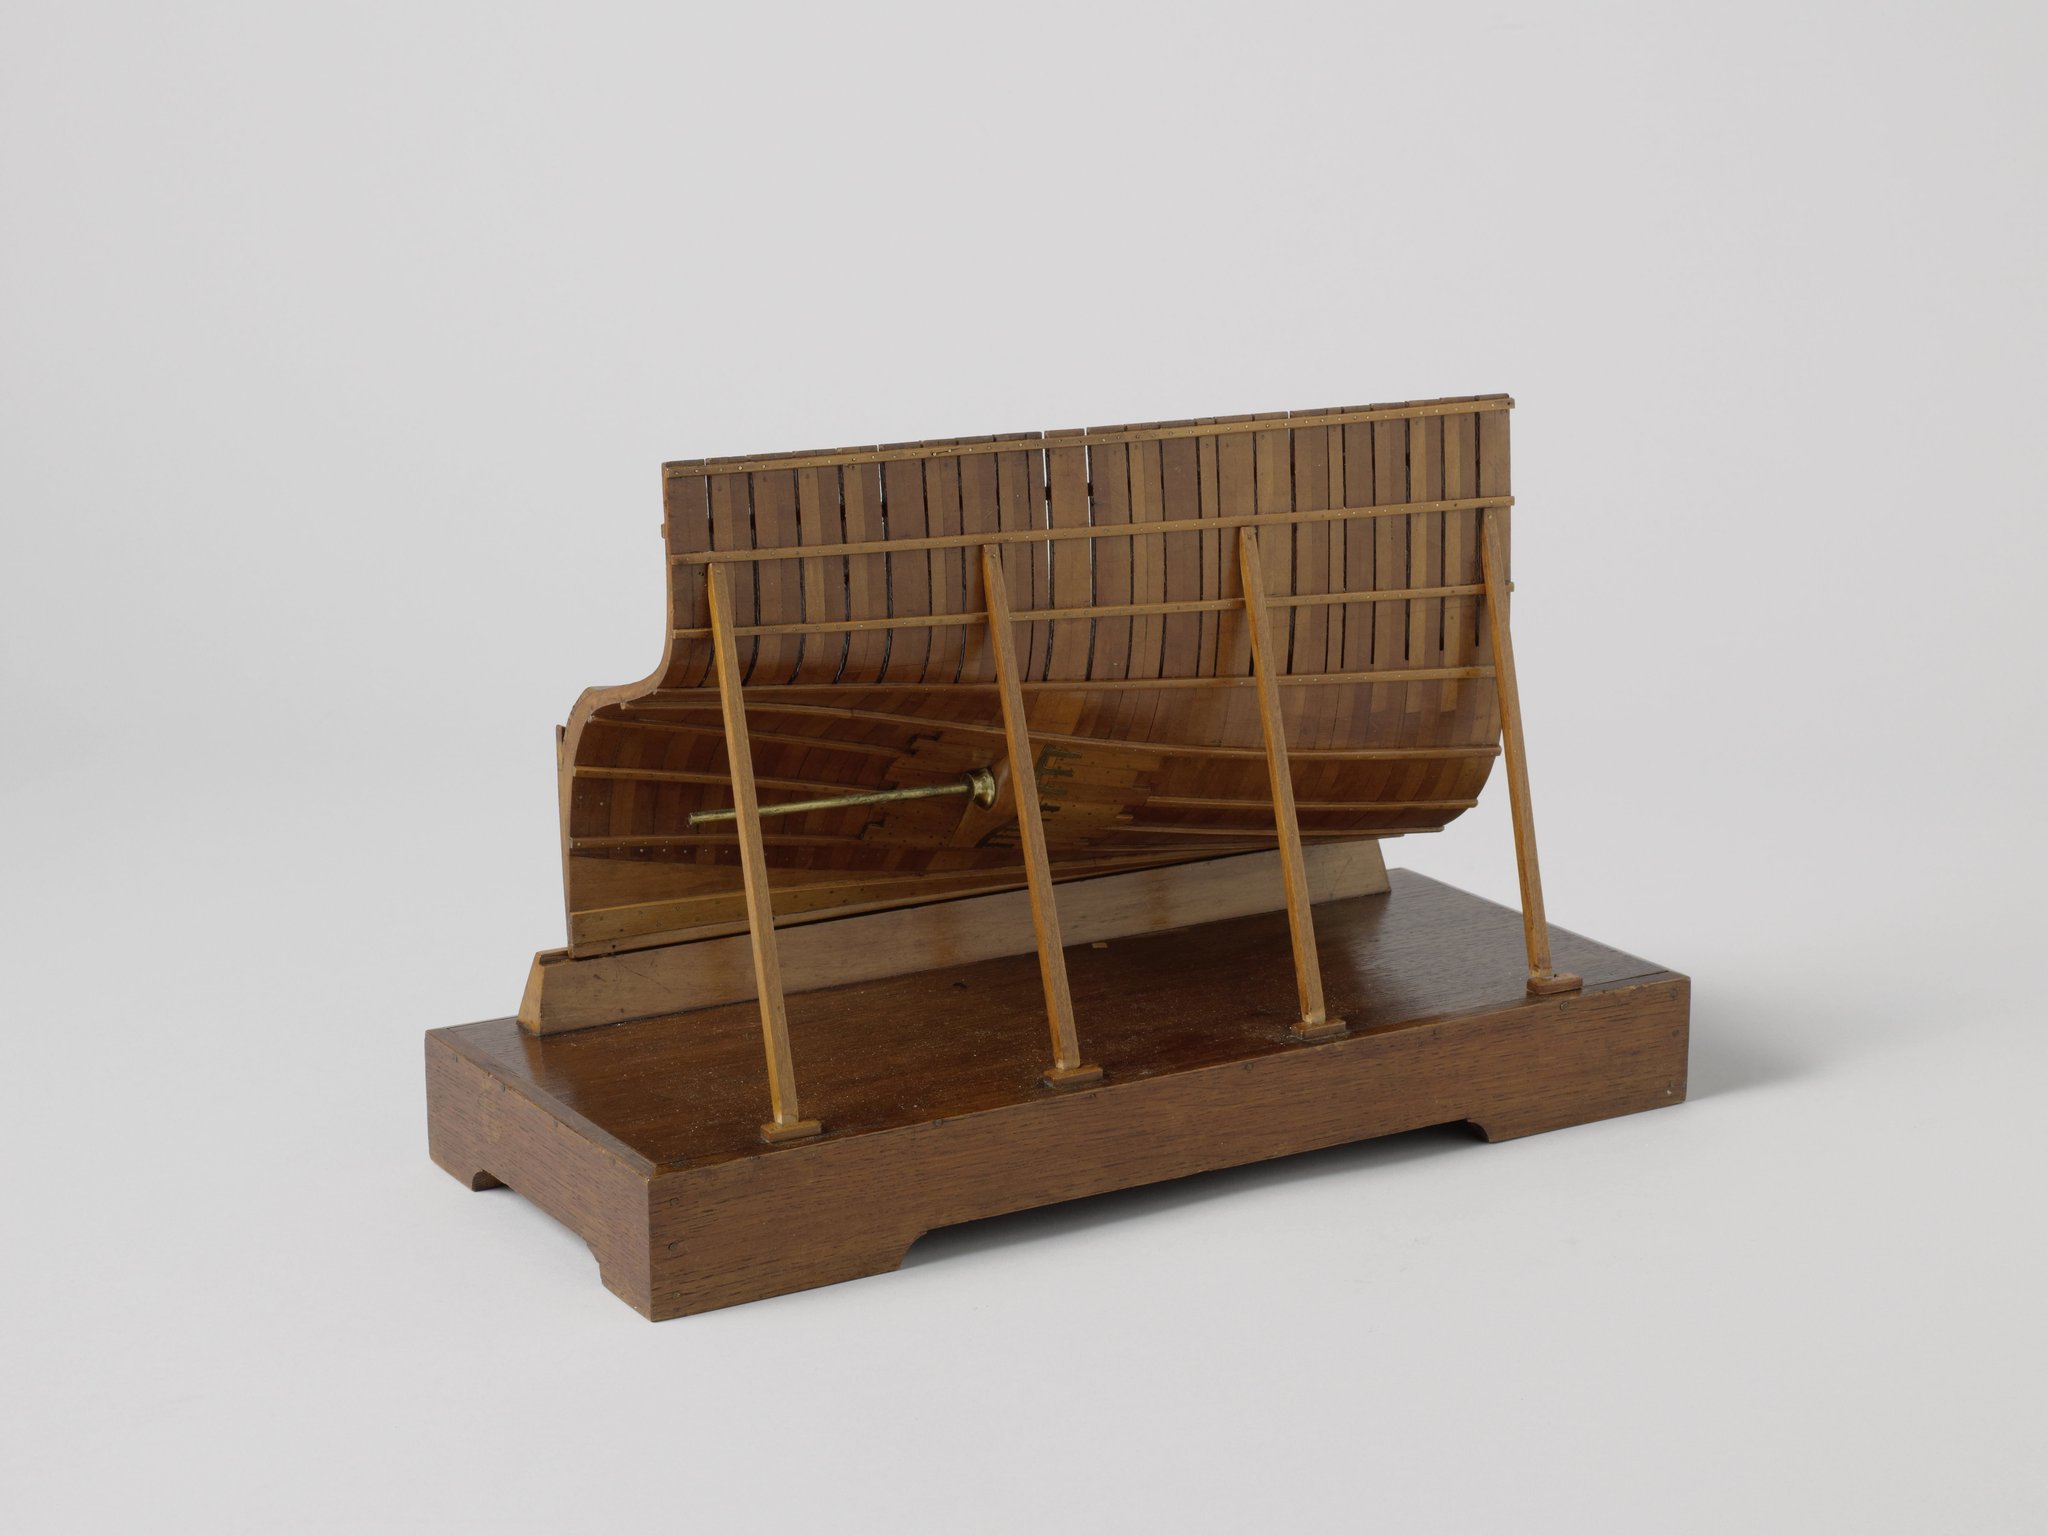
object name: construction model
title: Model of the Construction of the Screw Aperture for a Twin Screw Steamer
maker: Anonymous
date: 1864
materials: brass, wood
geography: netherlands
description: Model van een deel van het achterschip van een houten schip (stuurboordzijde), op een grondplank. Het model laat de kiel zien, de spanten met senten en een deel van de wegering en de schroefas. De spanten vlak voor en vlak achter de schroefas-pakking zijn verschillend van vorm, om de as ertussendoor te laten lopen. De pakking zit in een dik houten blok, aan de buitenzijde verstevigd met een getande metalen plaat en aan de binnenzijde met een dwarsscheeps liggende balk en metalen knie.